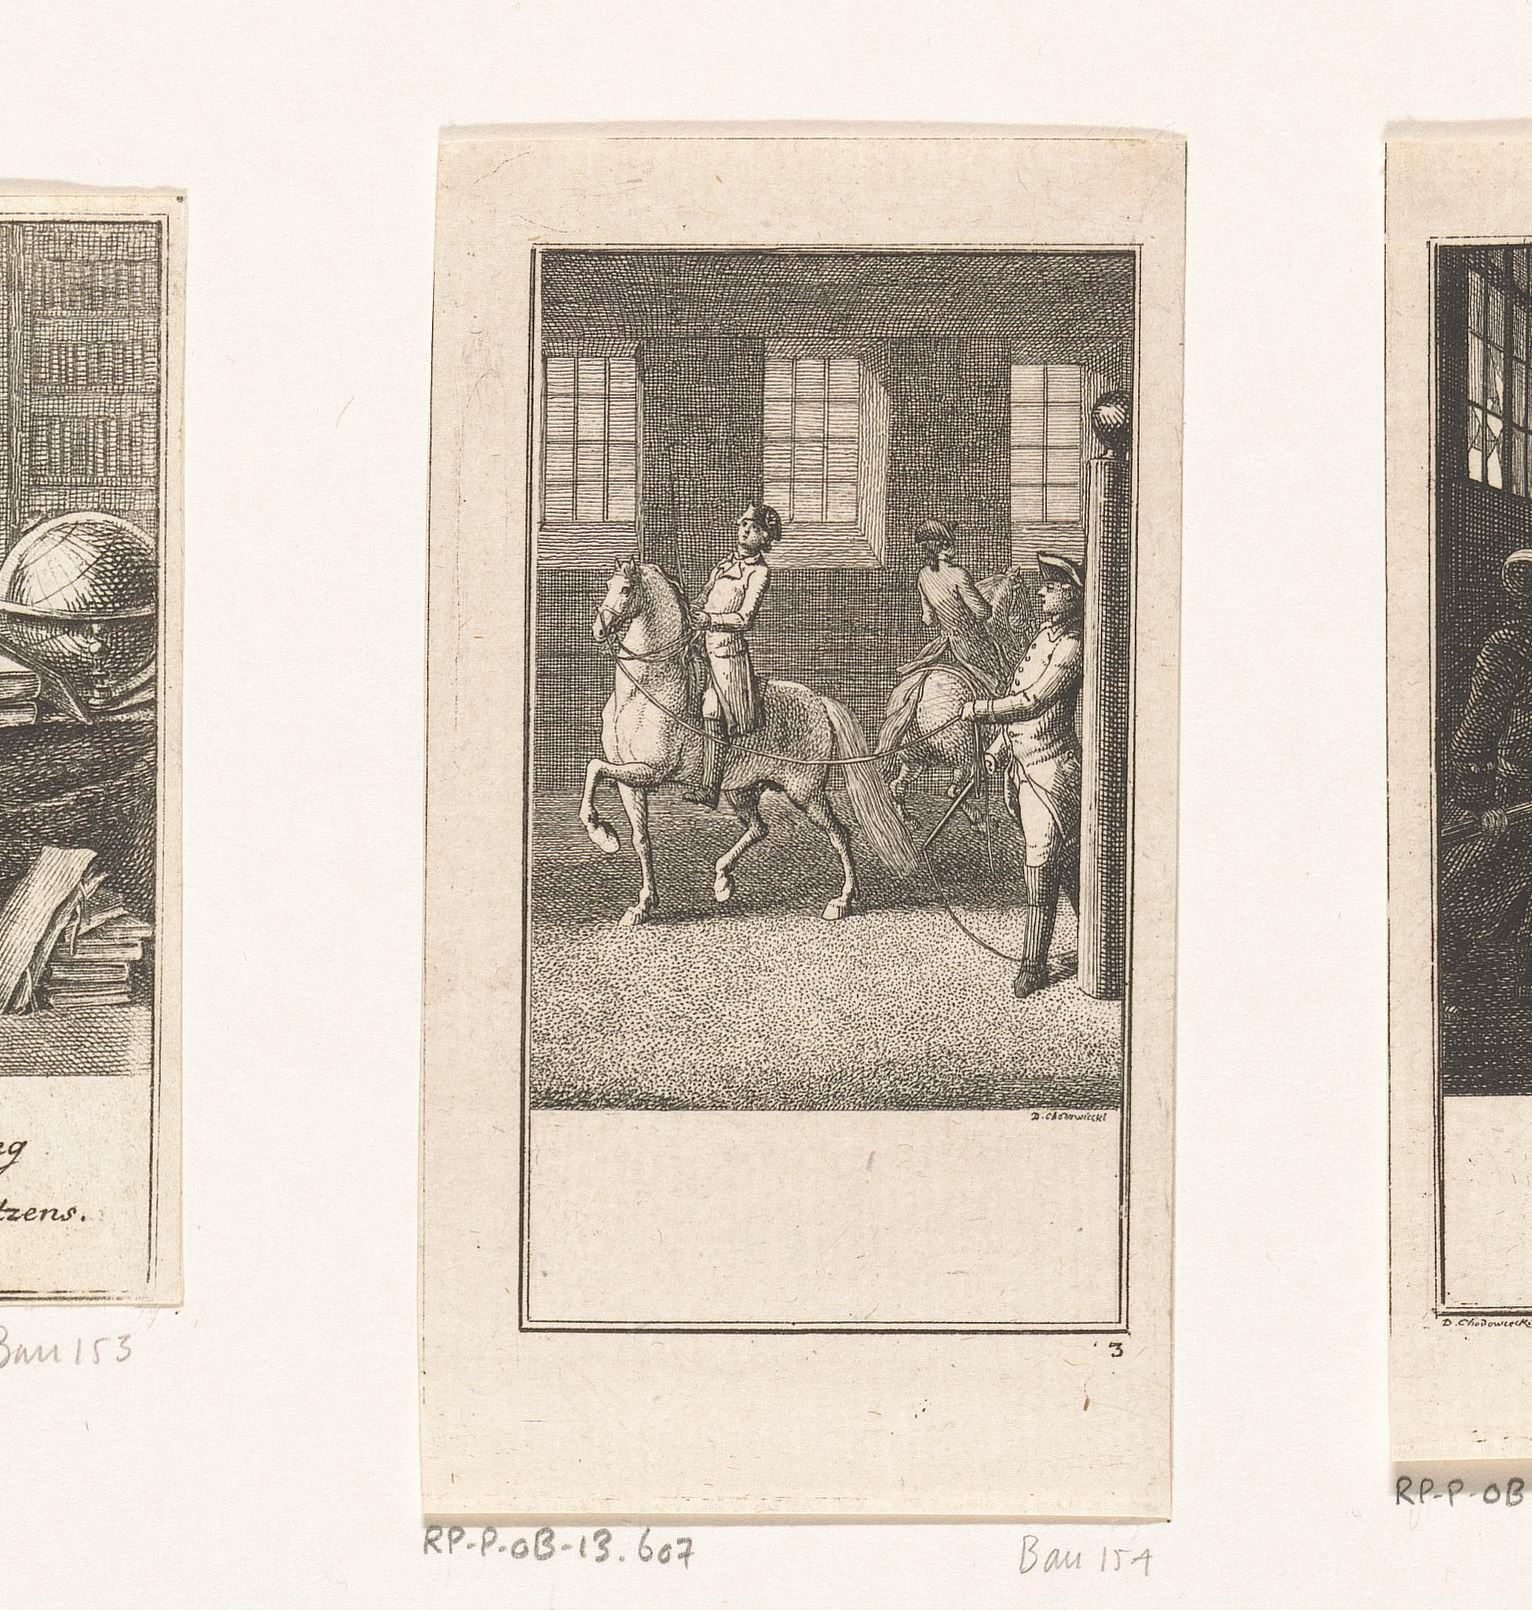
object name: print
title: Voorbereiding op de universiteit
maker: daniel nikolaus chodowiecki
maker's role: draughtsman, print maker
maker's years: 1726-1801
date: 1773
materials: paper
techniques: etching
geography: berlin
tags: riding-school, manège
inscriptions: collector's mark: Lugt 2228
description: Derde prent uit een serie met 12 scènes uit 'een liederlijk leven'. De twaalf scènes werden samen op een plaat geëtst. De tweede staat van deze serie is gebruikt als illustratie in: 'Berliner genealogischen Calender auf das Jahr 1774'. Aan de hand van deze prentserie schreef Johann Christian Ludwig Haken (1767-1835) zijn briefroman 'Der Lüderliche'.